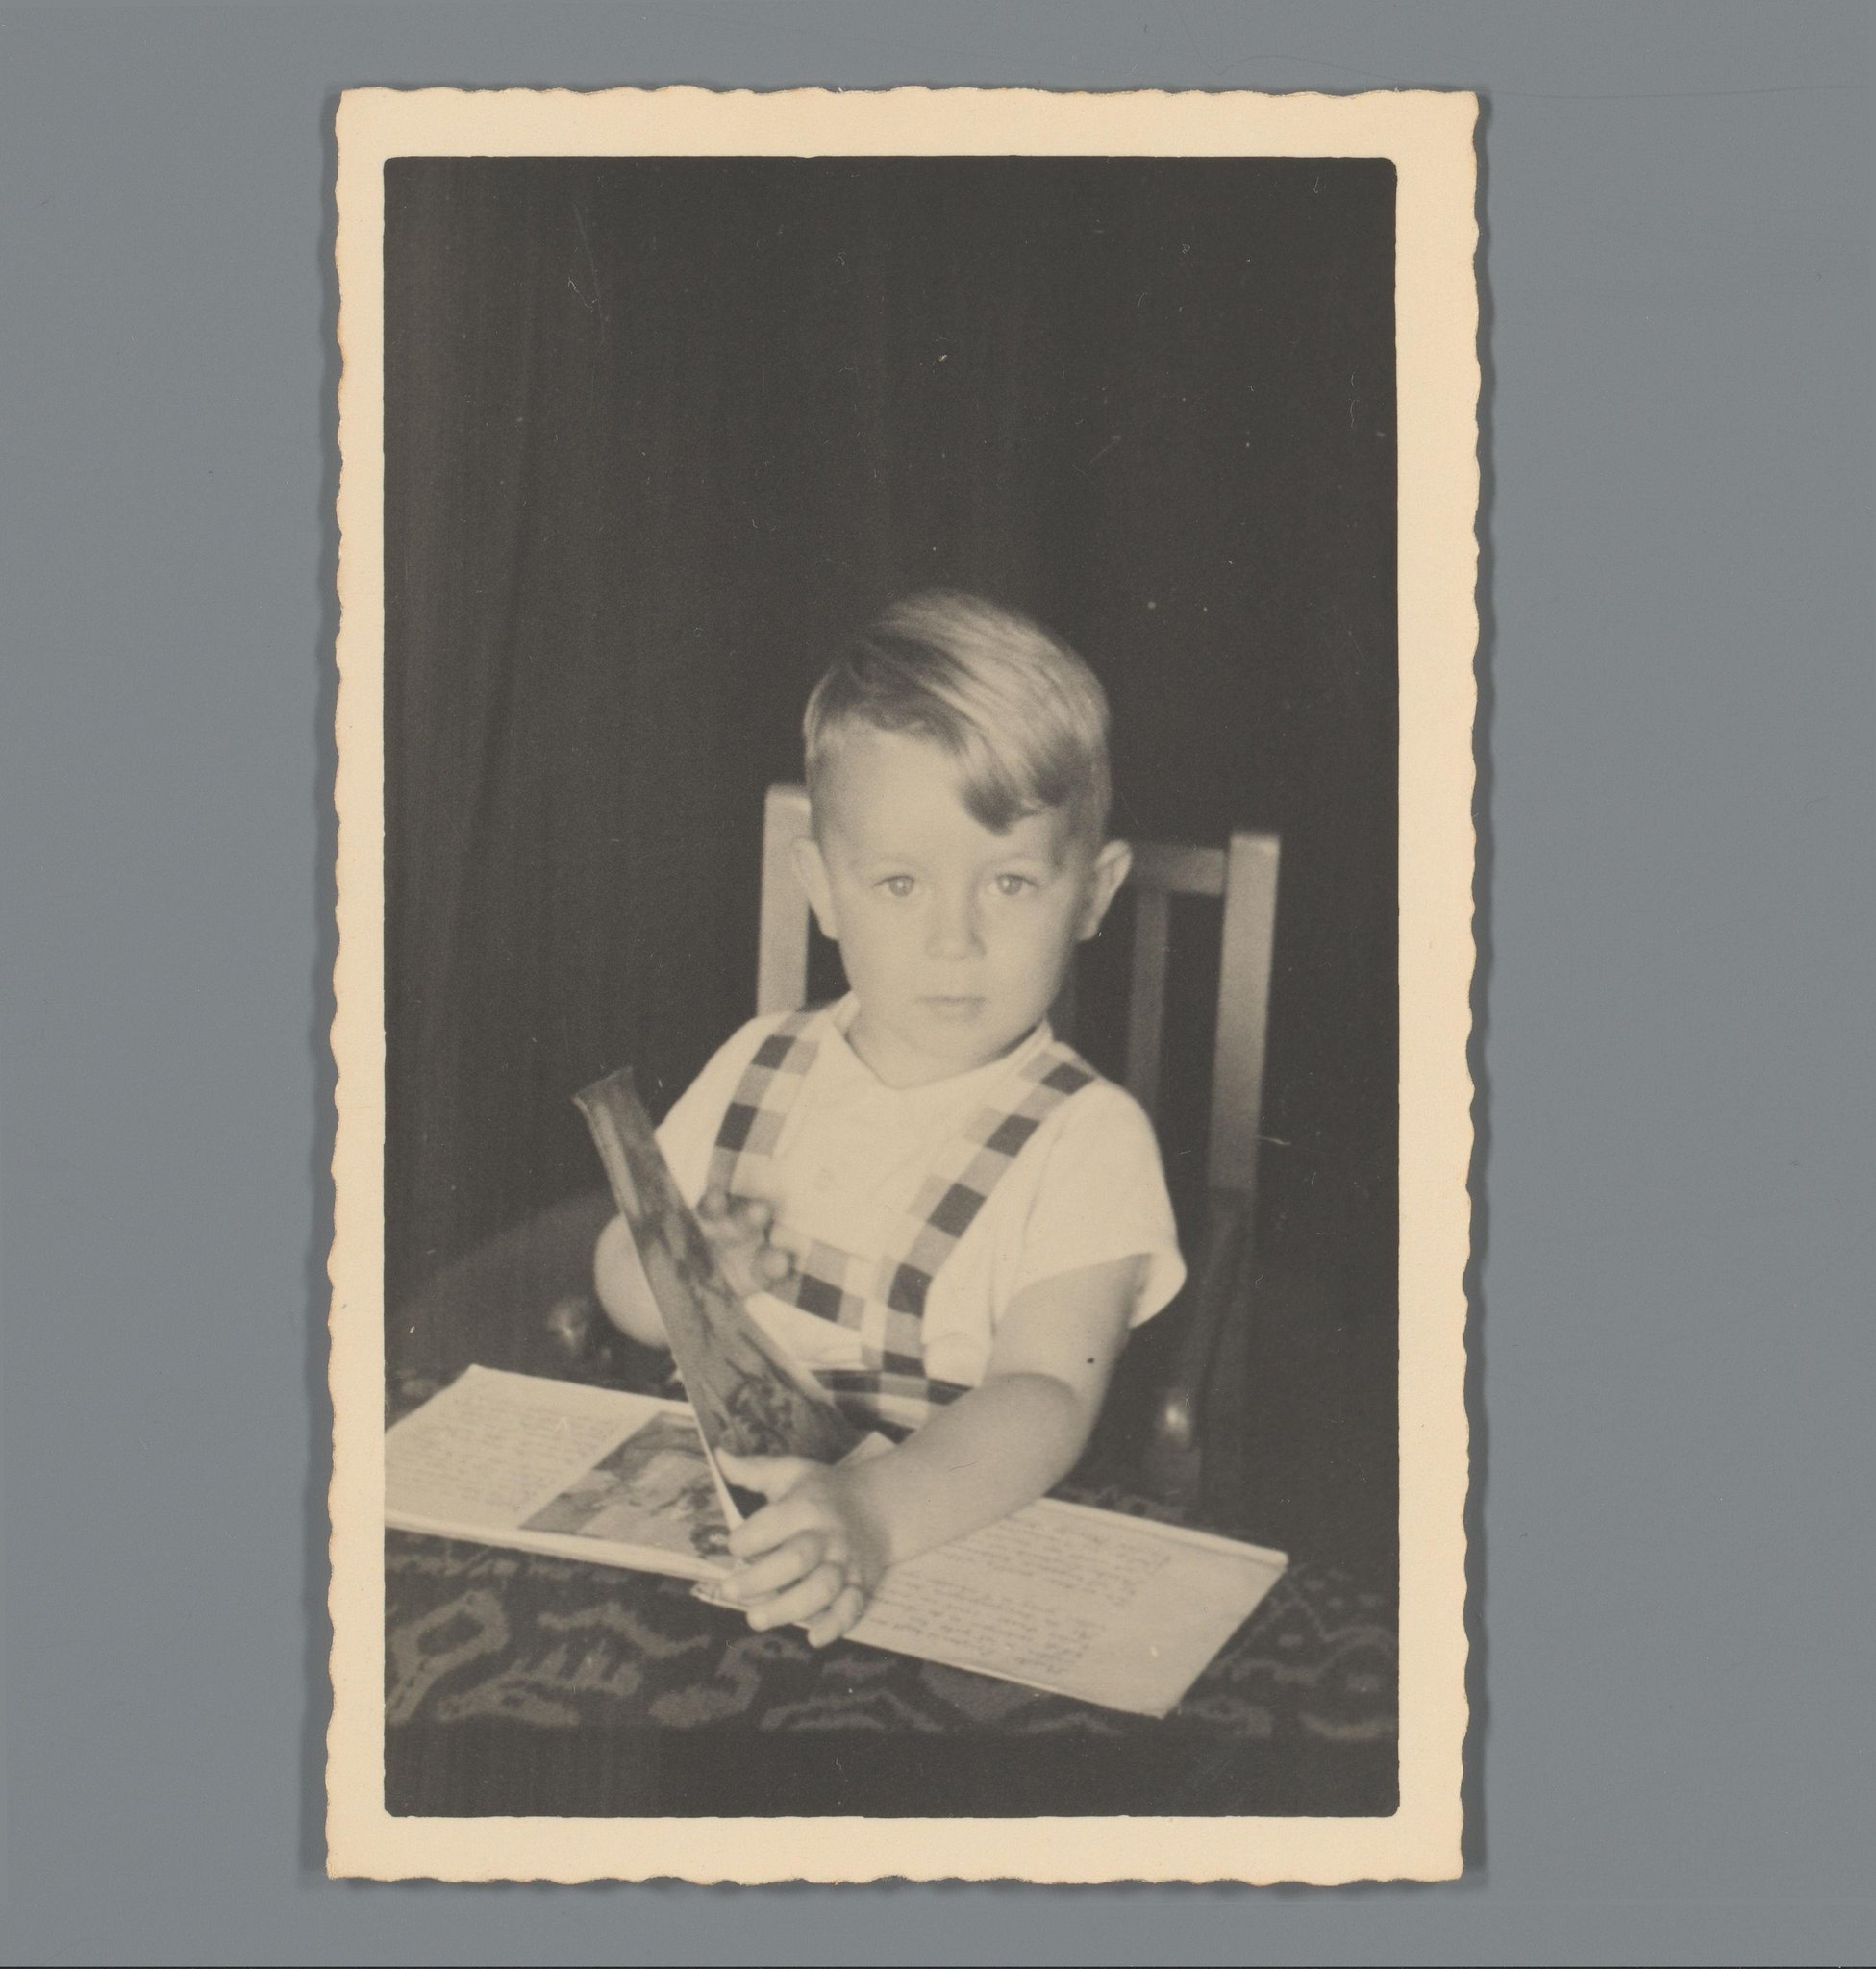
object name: photograph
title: Henk Swellengrebel als jongetje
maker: oosten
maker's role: fotograaf, fotohandel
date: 1945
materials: cardboard, photographic support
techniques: gelatin silver print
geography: delft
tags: delft, historical persons, child (at home)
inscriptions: inscription: ‘1945 HAM Swellengrebel Delft’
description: Henk Swellengrebel als jongetje zittend achter een prentenboek. Foto uitgevoerd als prentbriefkaart.